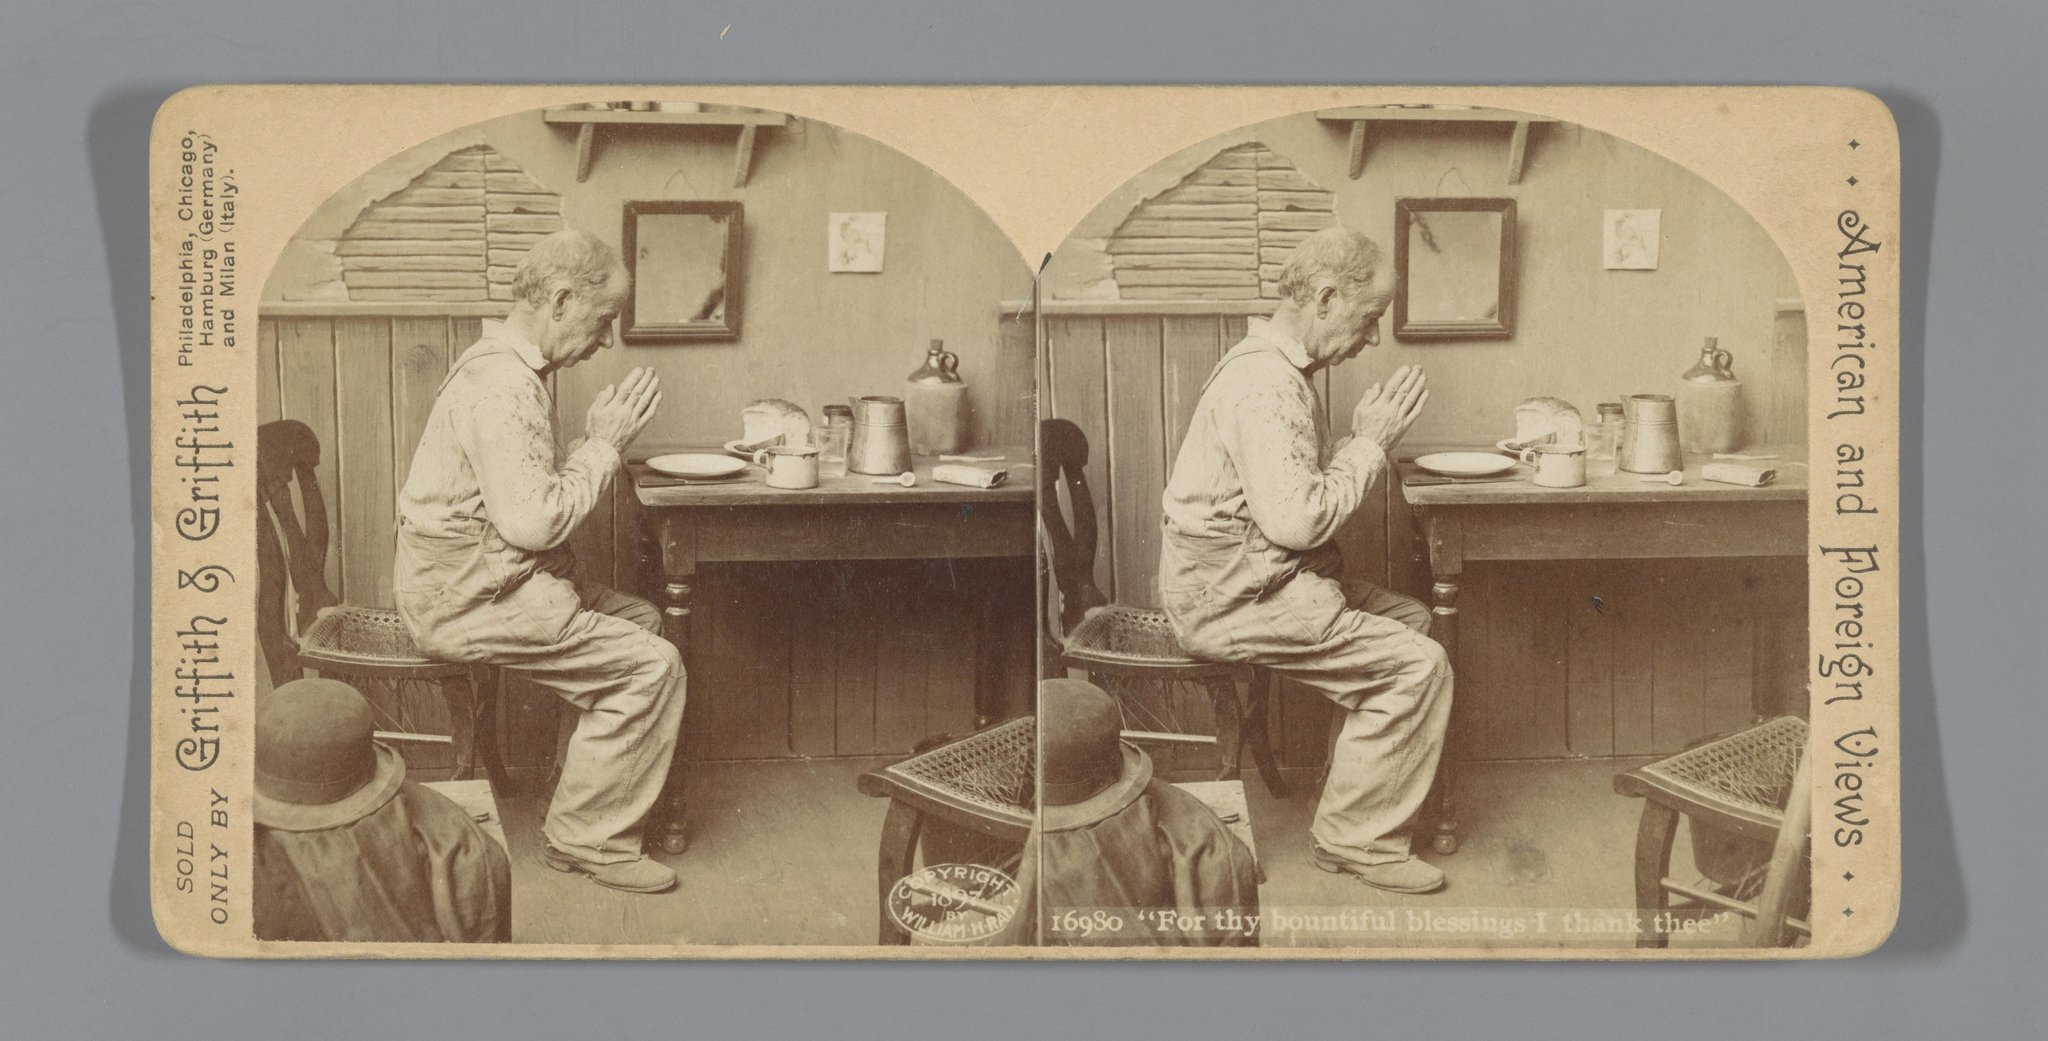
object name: stereograph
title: Man zit met gevouwen handen aan gedekte tafel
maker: william herman rau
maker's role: publisher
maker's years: 1855-1920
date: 1897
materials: cardboard, photographic support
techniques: albumen print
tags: one person praying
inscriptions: number: ‘16980’, workshop stamp: ‘Copyright / 1897 / William H. Rau’, name: ‘Sold only by Griffith & Griffith Philadelphia, Chicago, Hamburg (Germany) and Milan (Italy)’, number: ‘23’